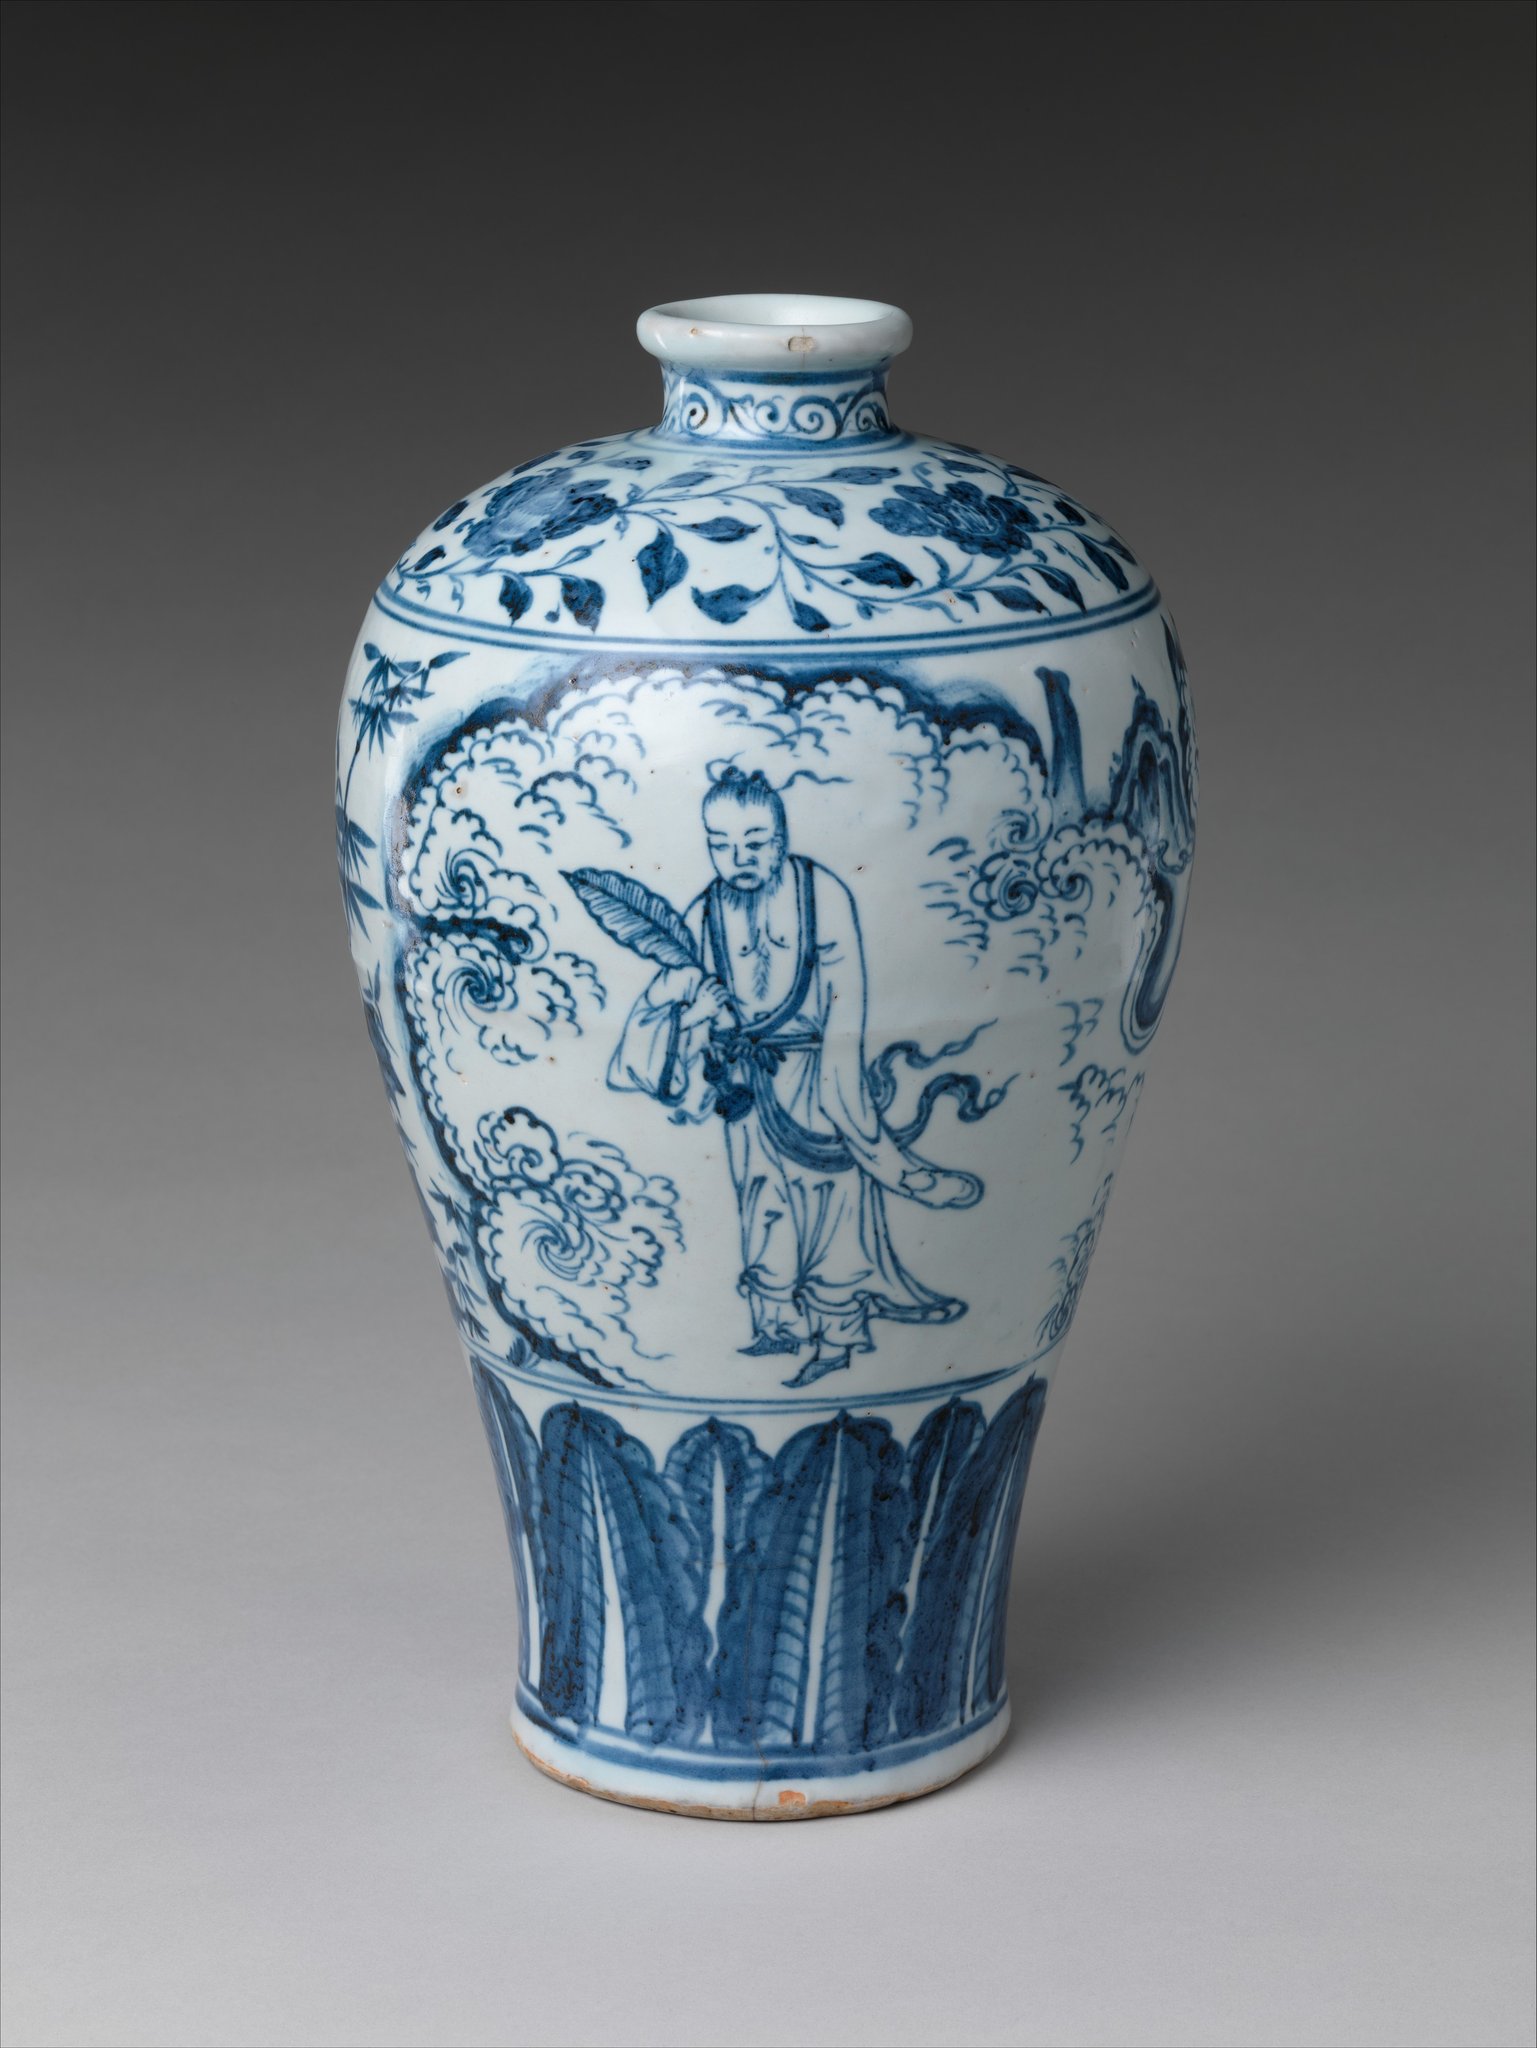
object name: vase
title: Vase in Meiping Shape with Daoist Immortal Zhongli Quan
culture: chinese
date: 1451-1500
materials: cobalt, glaze, porcelain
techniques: painting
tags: men,daoism